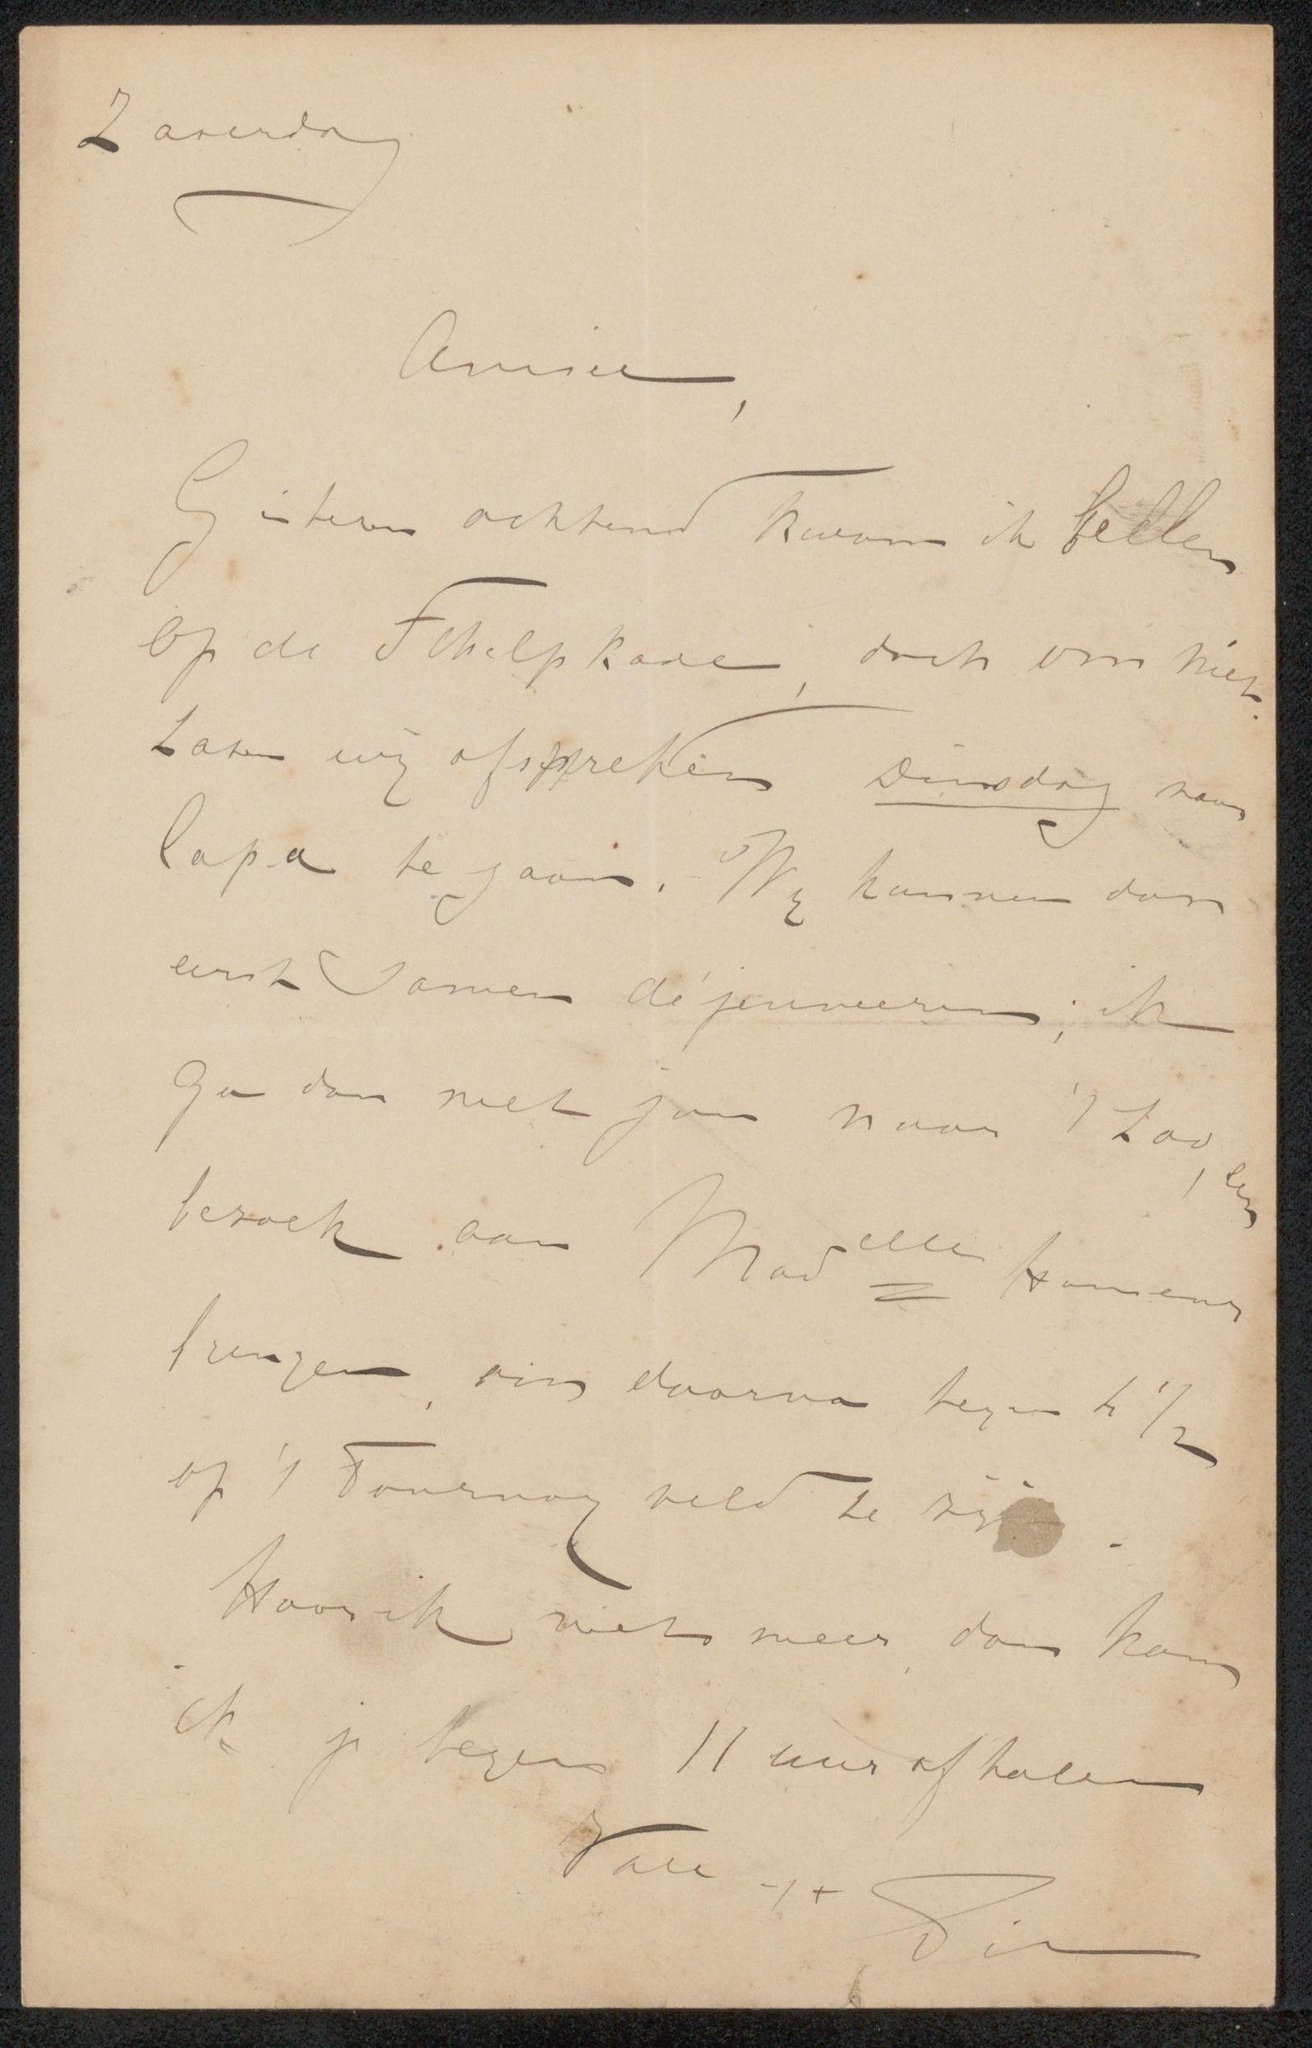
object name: letter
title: Brief aan Philip Zilcken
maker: adriaan pit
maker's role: print maker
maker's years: 1860-1944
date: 1870-1930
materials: ink, paper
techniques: pen, writing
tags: brussels, helène lambertine hauzeur, draughtsman, philip zilcken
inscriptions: collector's mark: ‘RPK’